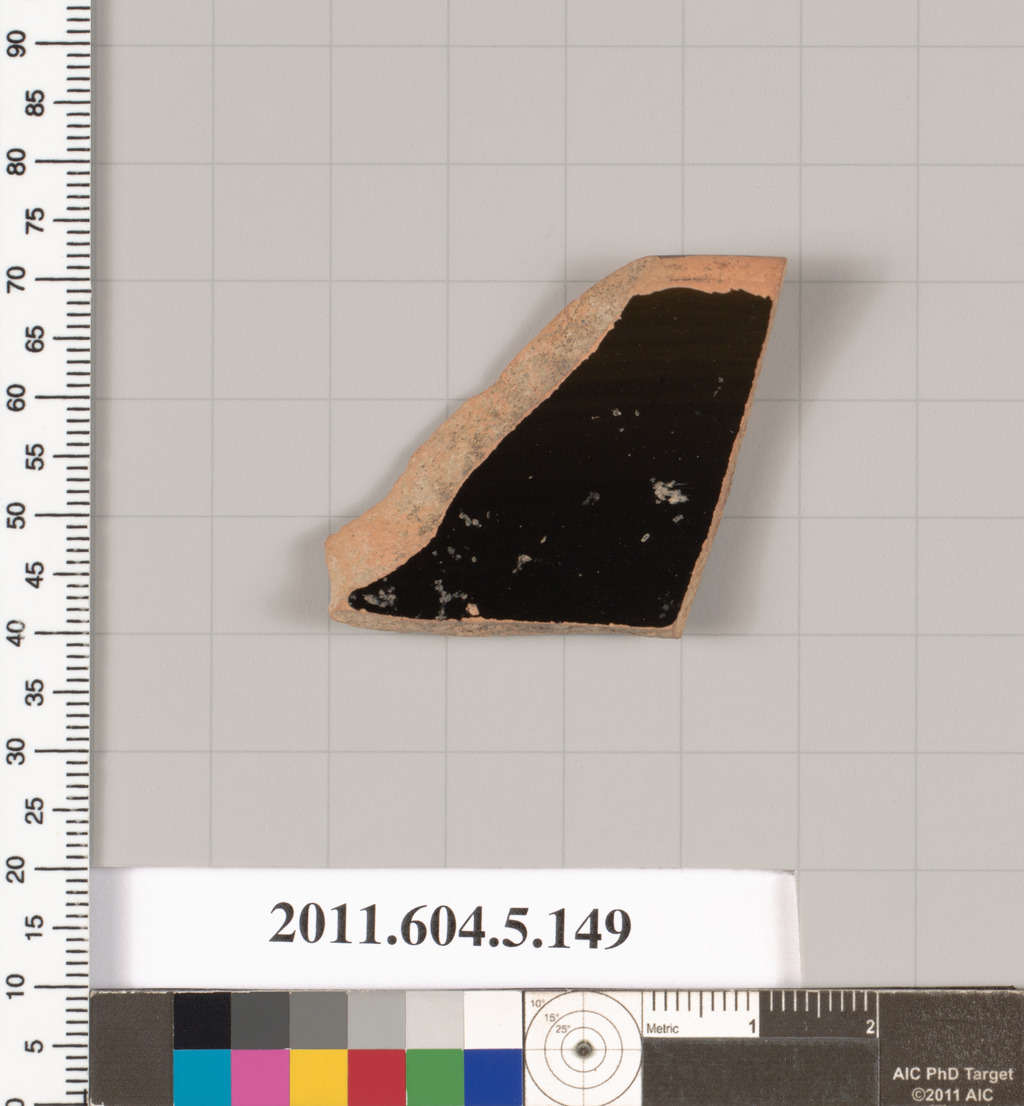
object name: kylix fragment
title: Terracotta rim fragment of a kylix (drinking cup)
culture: greek, attic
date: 600-401 BCE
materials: terracotta